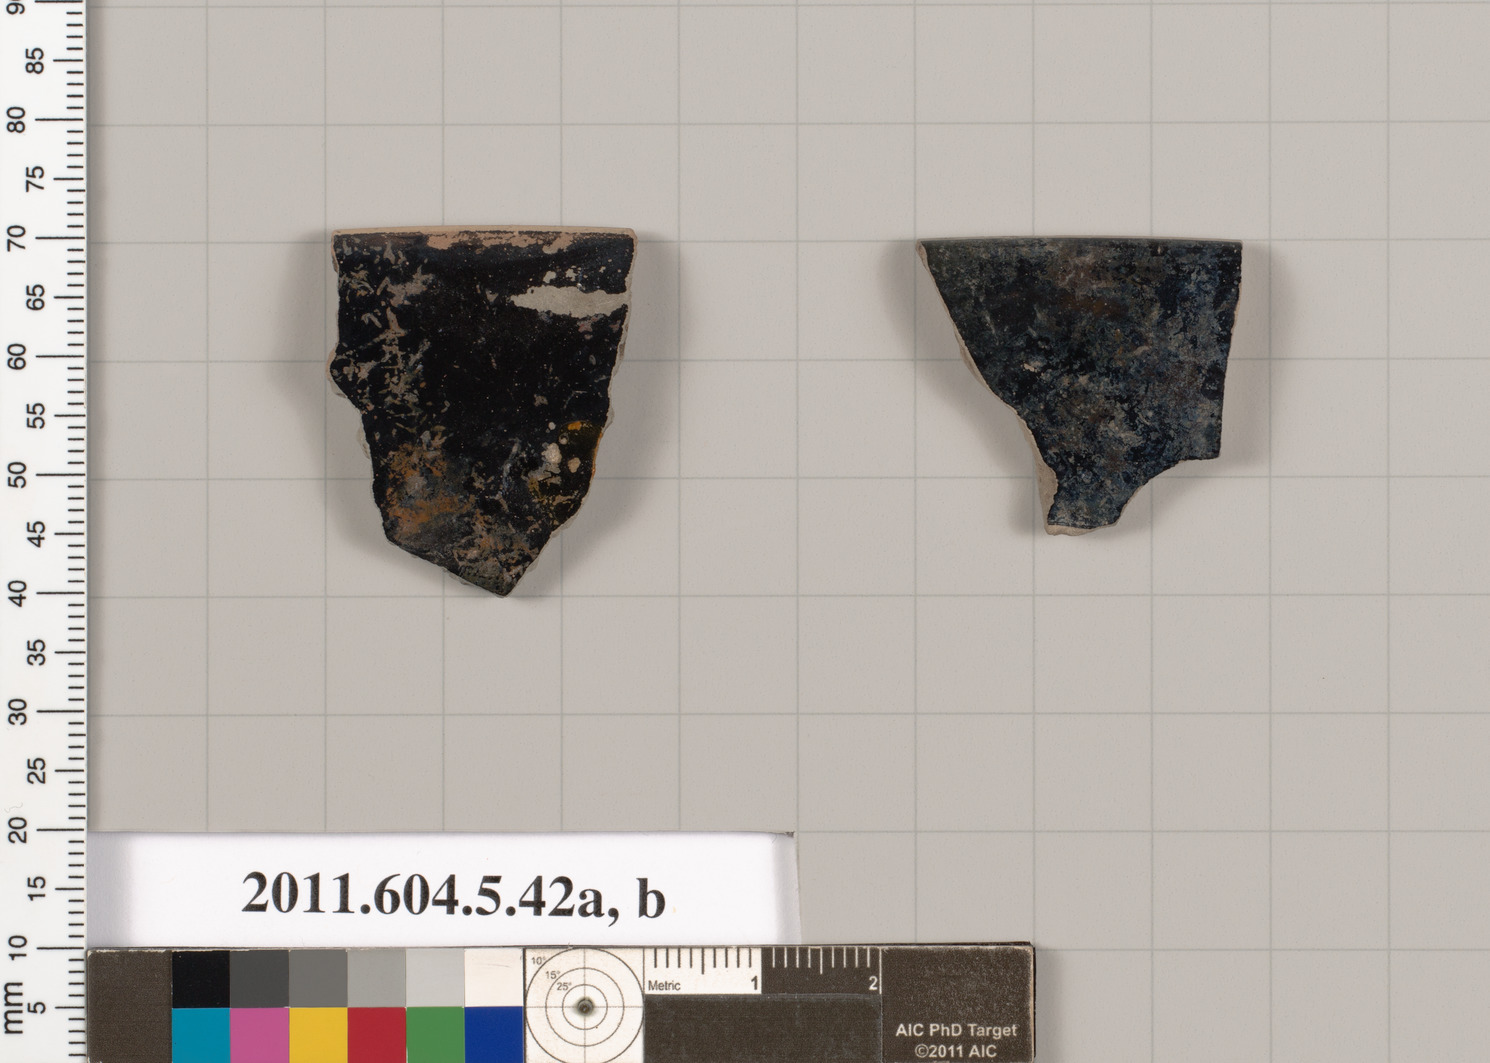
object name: kylix fragment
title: Terracotta rim fragments of a kylix (drinking cup)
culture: greek, attic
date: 500-401 BCE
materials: terracotta